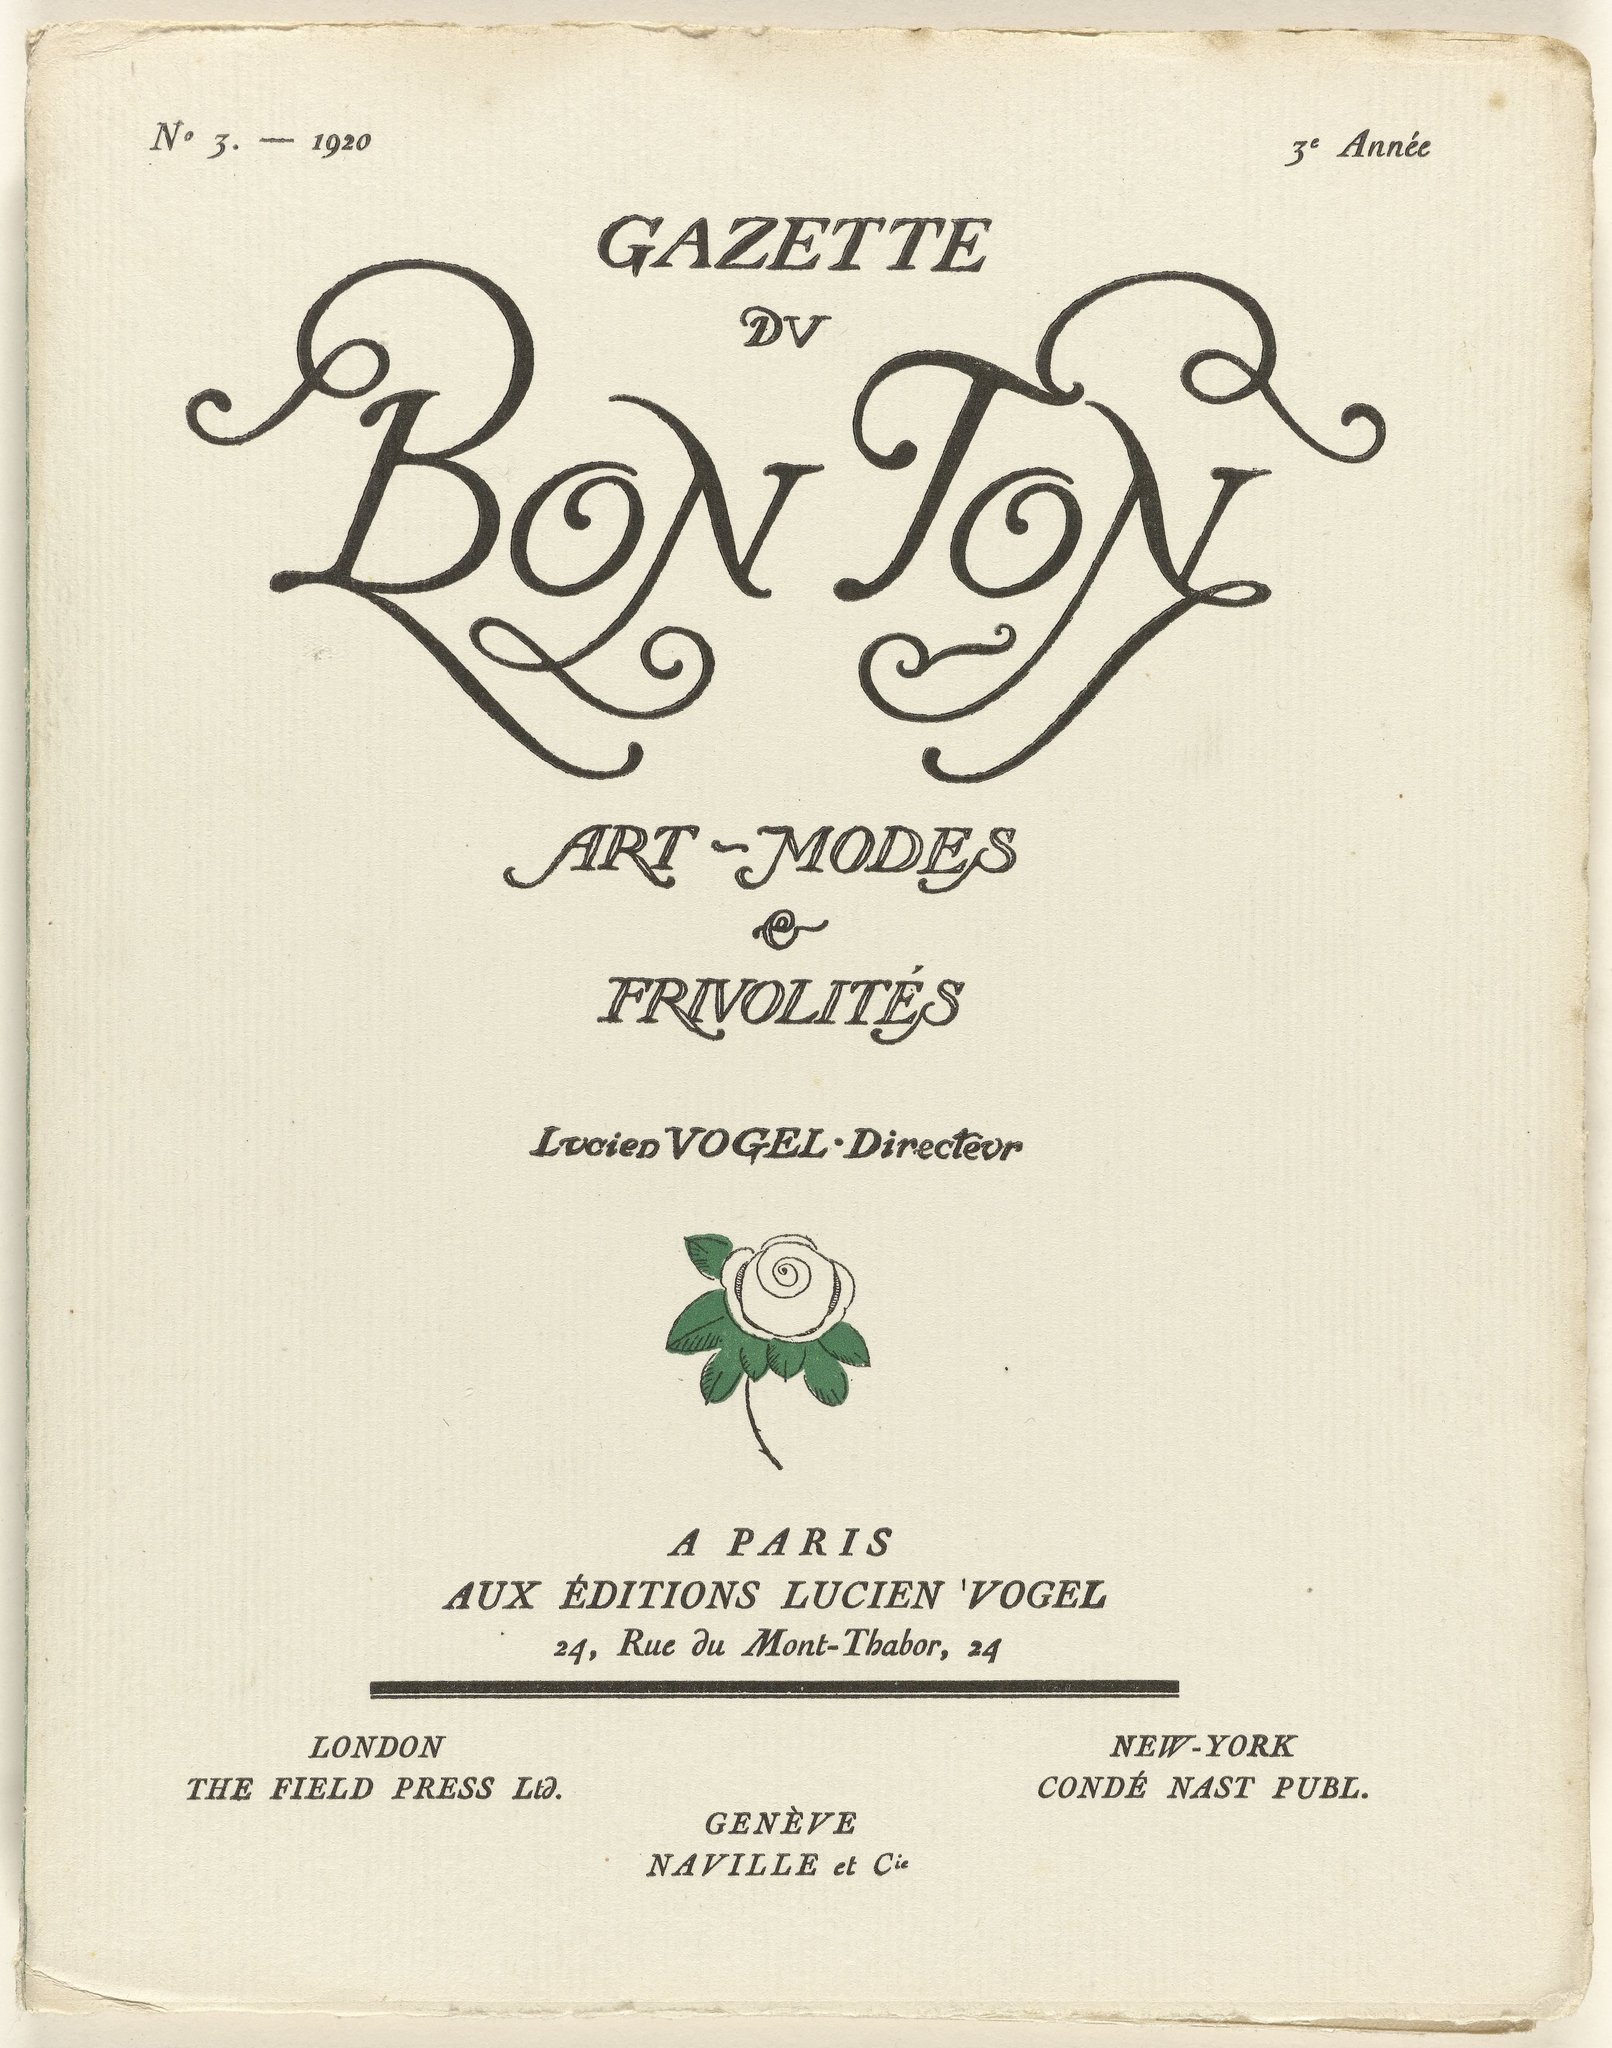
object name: magazine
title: Gazette du Bon Ton. Art - Modes & Frivolités, 1920, 3e Année, No. 3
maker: lucien vogel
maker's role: publisher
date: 1920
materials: paper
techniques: letterpress printing, pochoir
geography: geneva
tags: fashion plates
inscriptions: date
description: Aflevering No. 3, april 1920, van Gazette du Bon Ton, bestaand uit een omslag, negen katernen met tekst en illustraties en twaalf losse prenten. Aan dit deel werkten de volgende modeontwerpers mee: Beer, Cheruit, Doeuillet, Doucet, Lanvin, Paquin, Paul Poiret, Redfern en Worth.